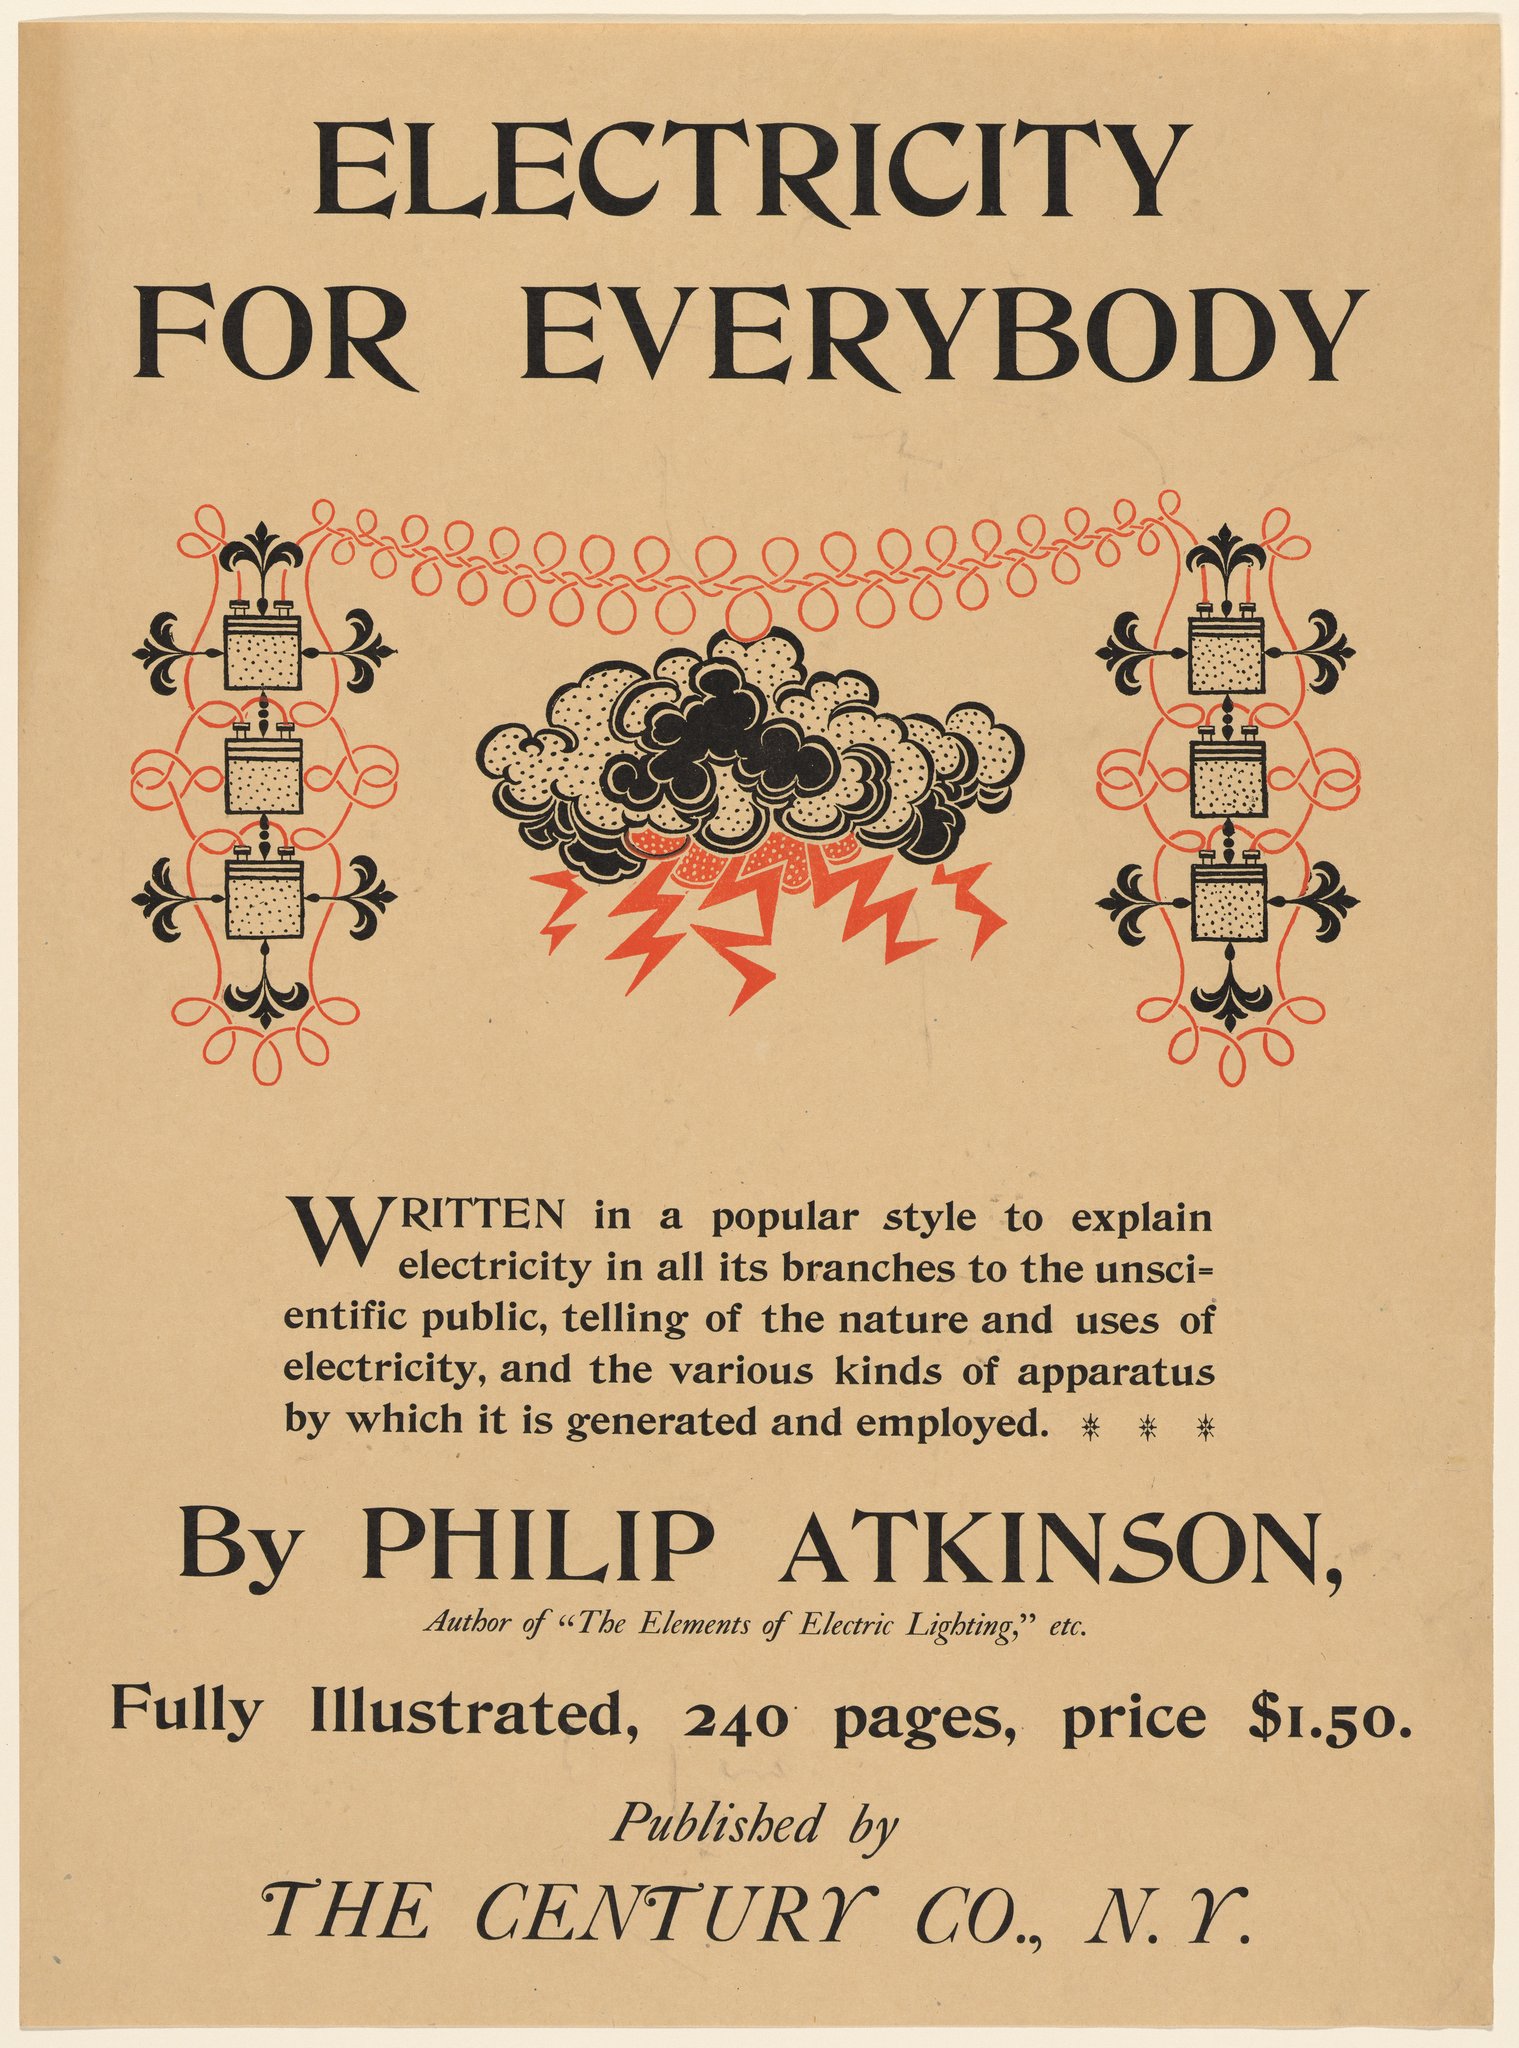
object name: print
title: Electricity for Everybody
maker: anonymous, american, 19th century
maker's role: artist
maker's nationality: american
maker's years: 1800-1900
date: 1895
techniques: lithograph